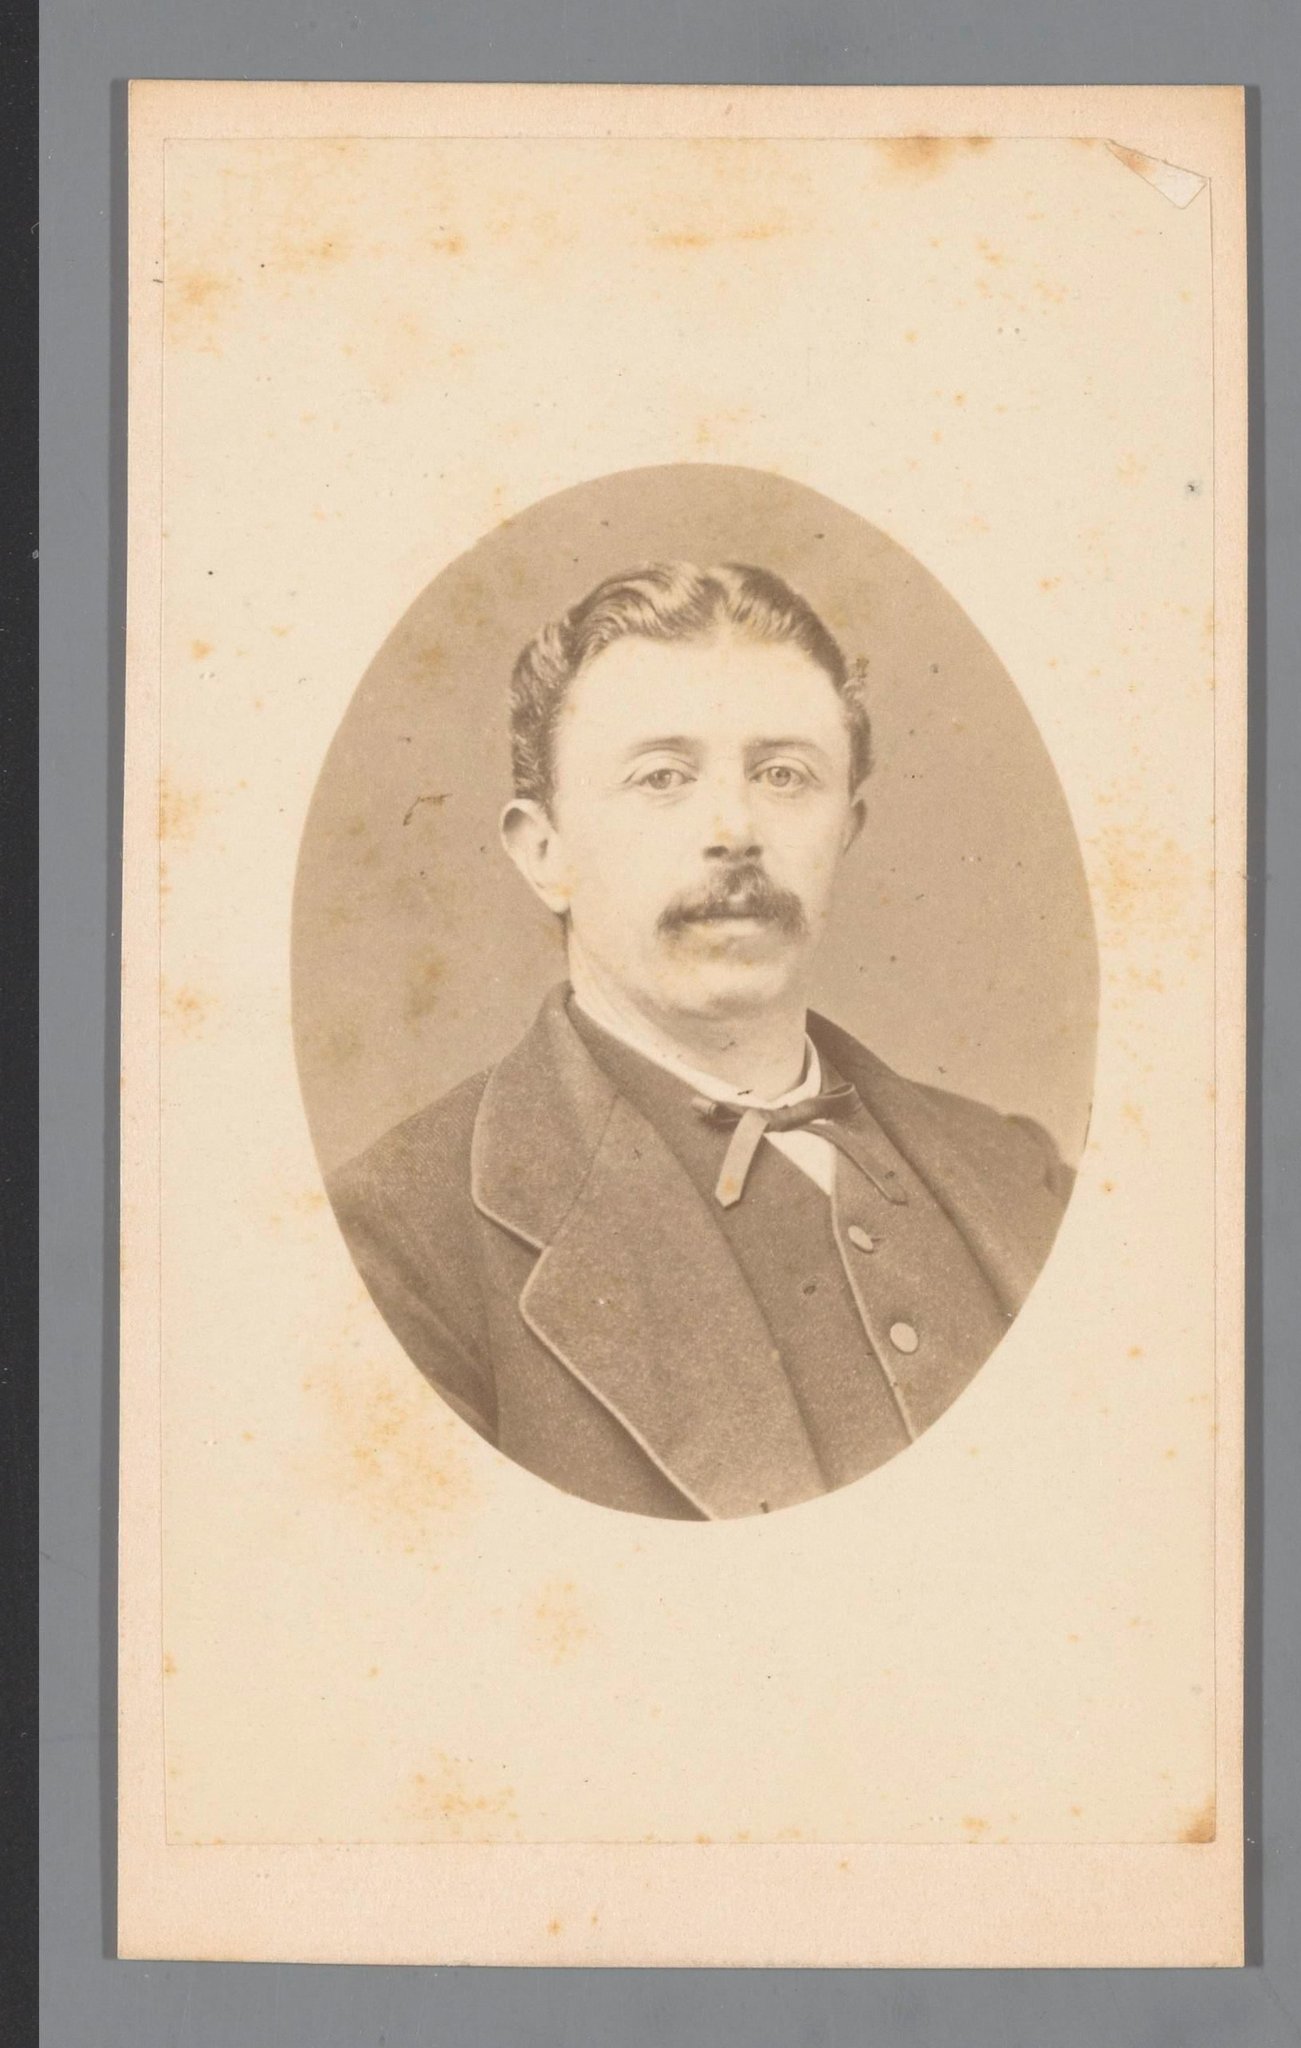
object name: carte de visite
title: Portret van Jouwert Witteveen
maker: Anonymous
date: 1860-1890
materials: cardboard, paper, photographic support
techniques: albumen print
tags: witteveen, jouwert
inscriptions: annotation: ‘J. Witteveen/burgemeester/van Kollum’